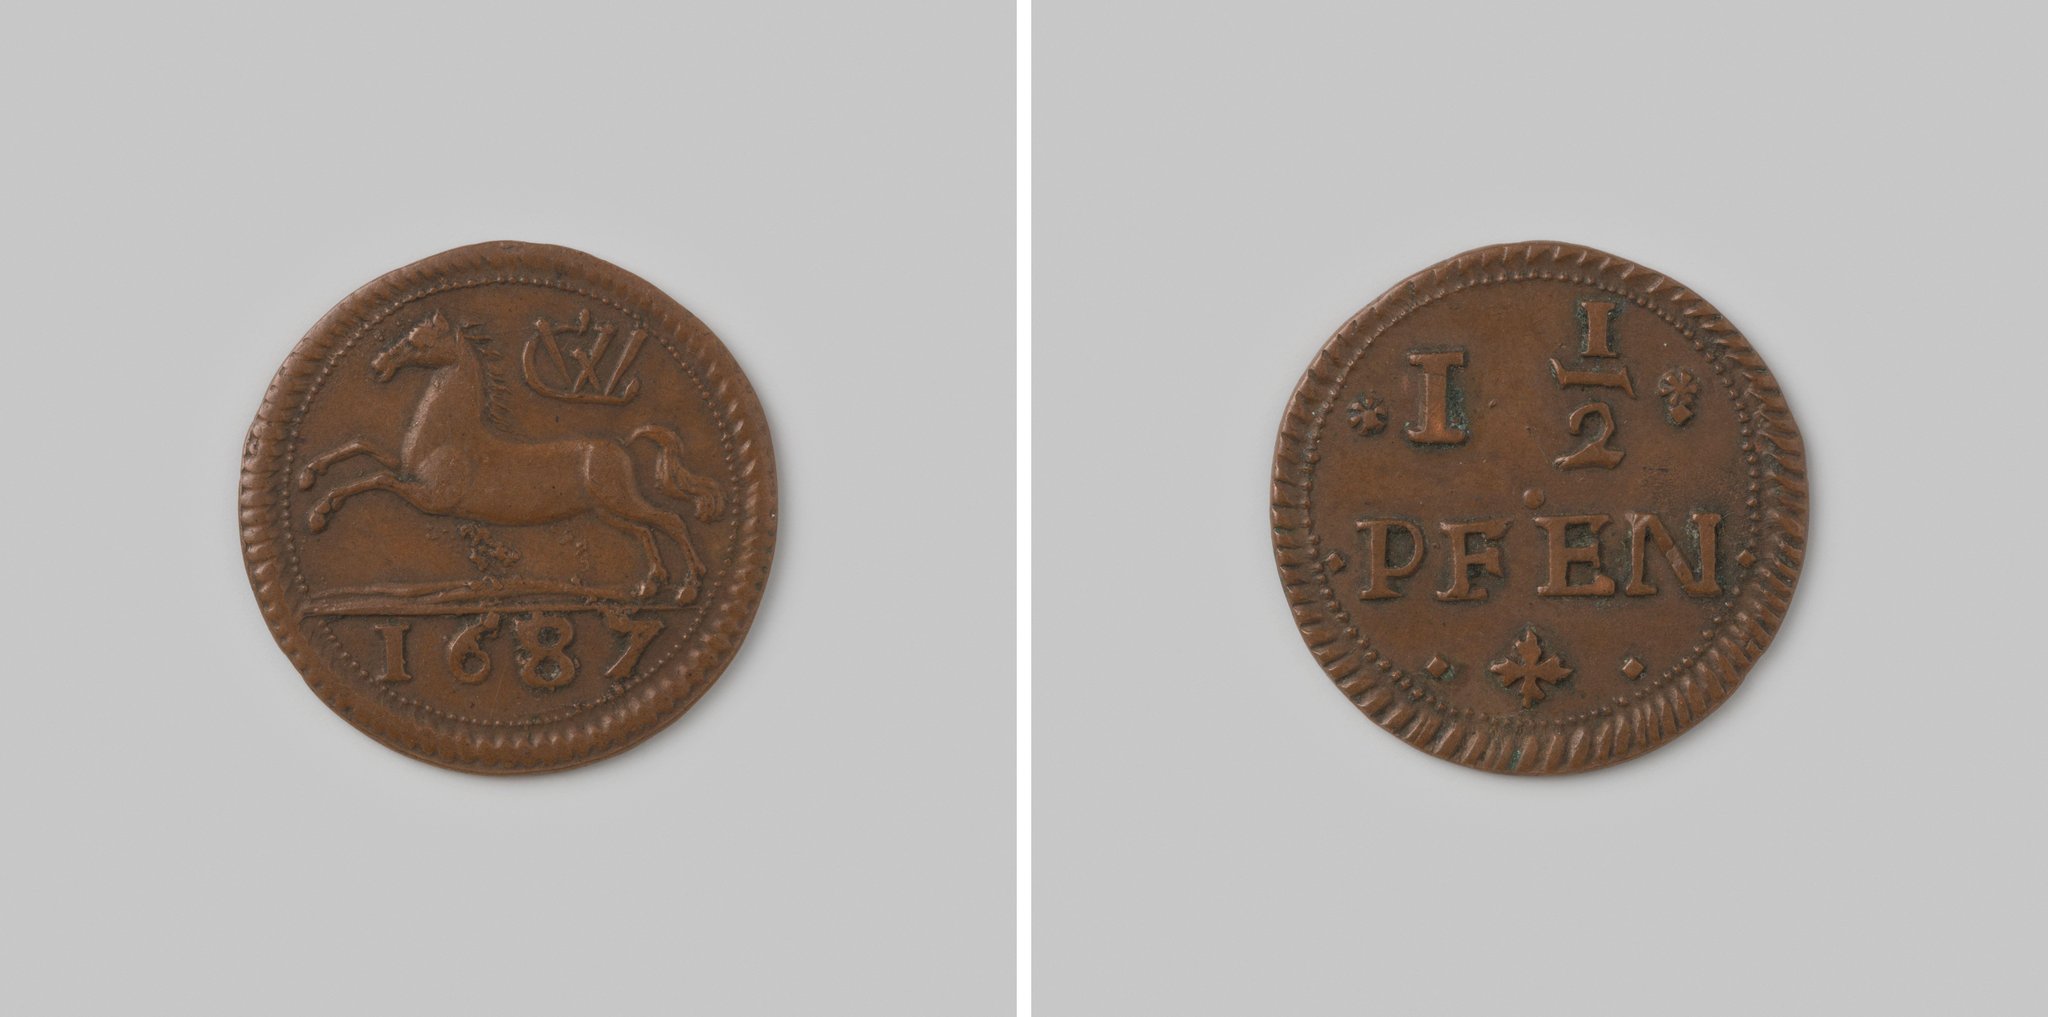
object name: coin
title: Brunswijk-Luneburg-Celle, Georg Wilhelm, 1½ Pfennig, 1687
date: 1687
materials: copper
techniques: striking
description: Koperen munt. Voorzijde: paard in galop naar links. Daarboven rechts monogram van de vorst en daaronder jaartal. Keerzijde: waarde-aanduiding in twee regels. Gladde rand.